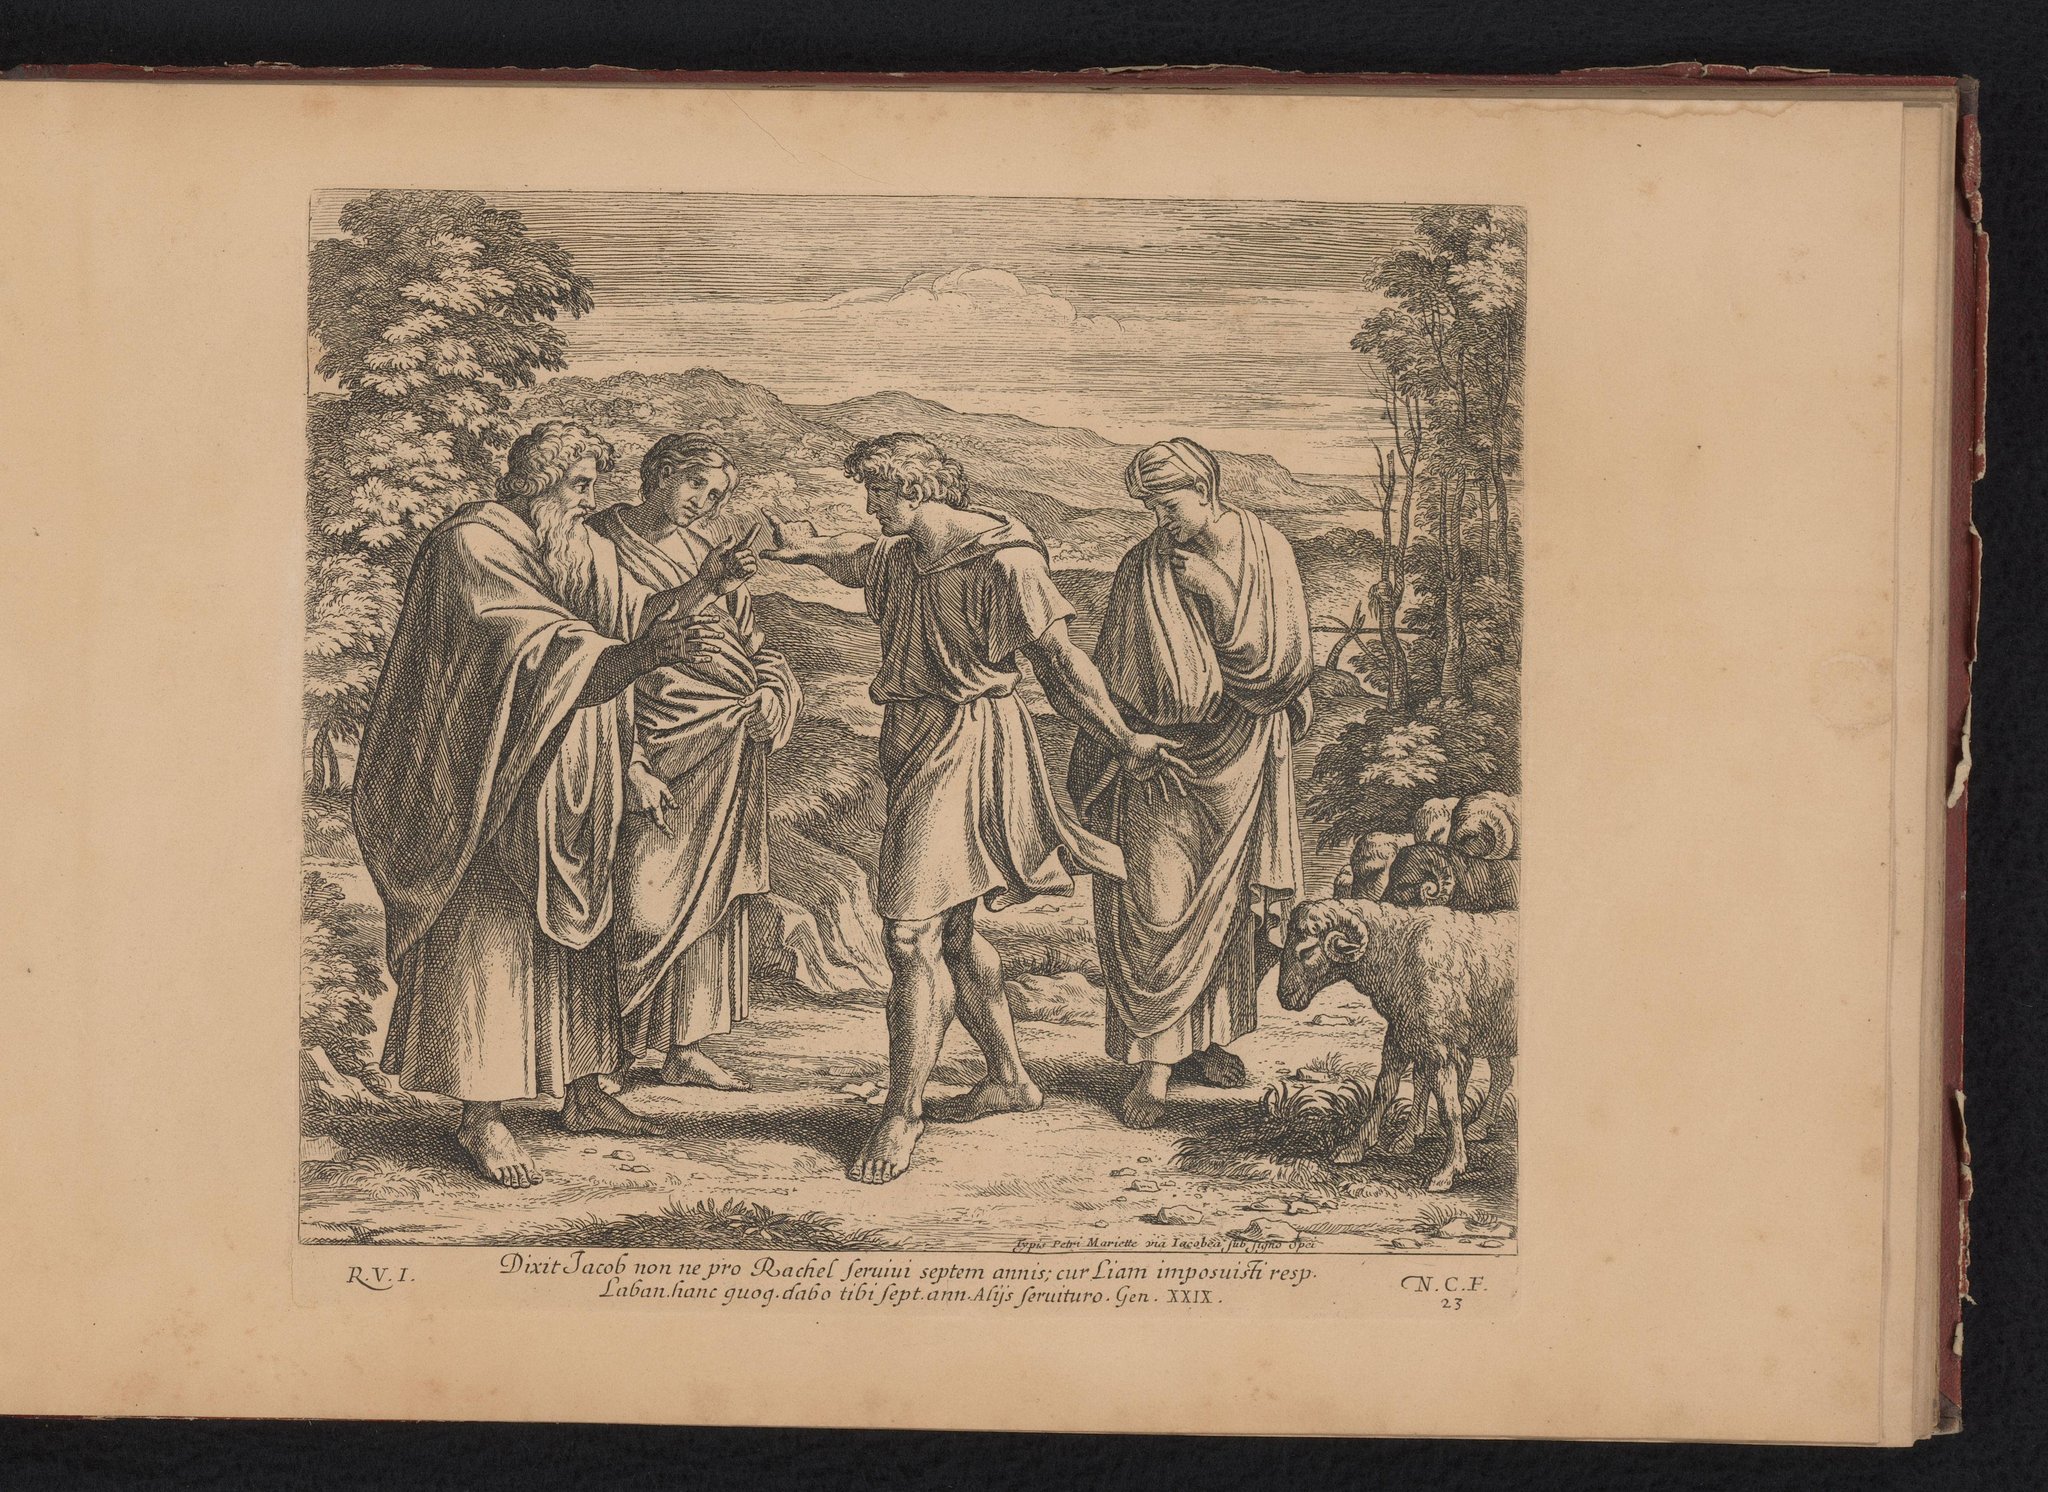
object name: album leaf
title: Rafaël Bijbel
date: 1649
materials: paper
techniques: etching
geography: paris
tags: after the wedding-night jacob discovers that he has been deceived with leah and complains to laban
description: Deze prent maakt deel uit van een album.